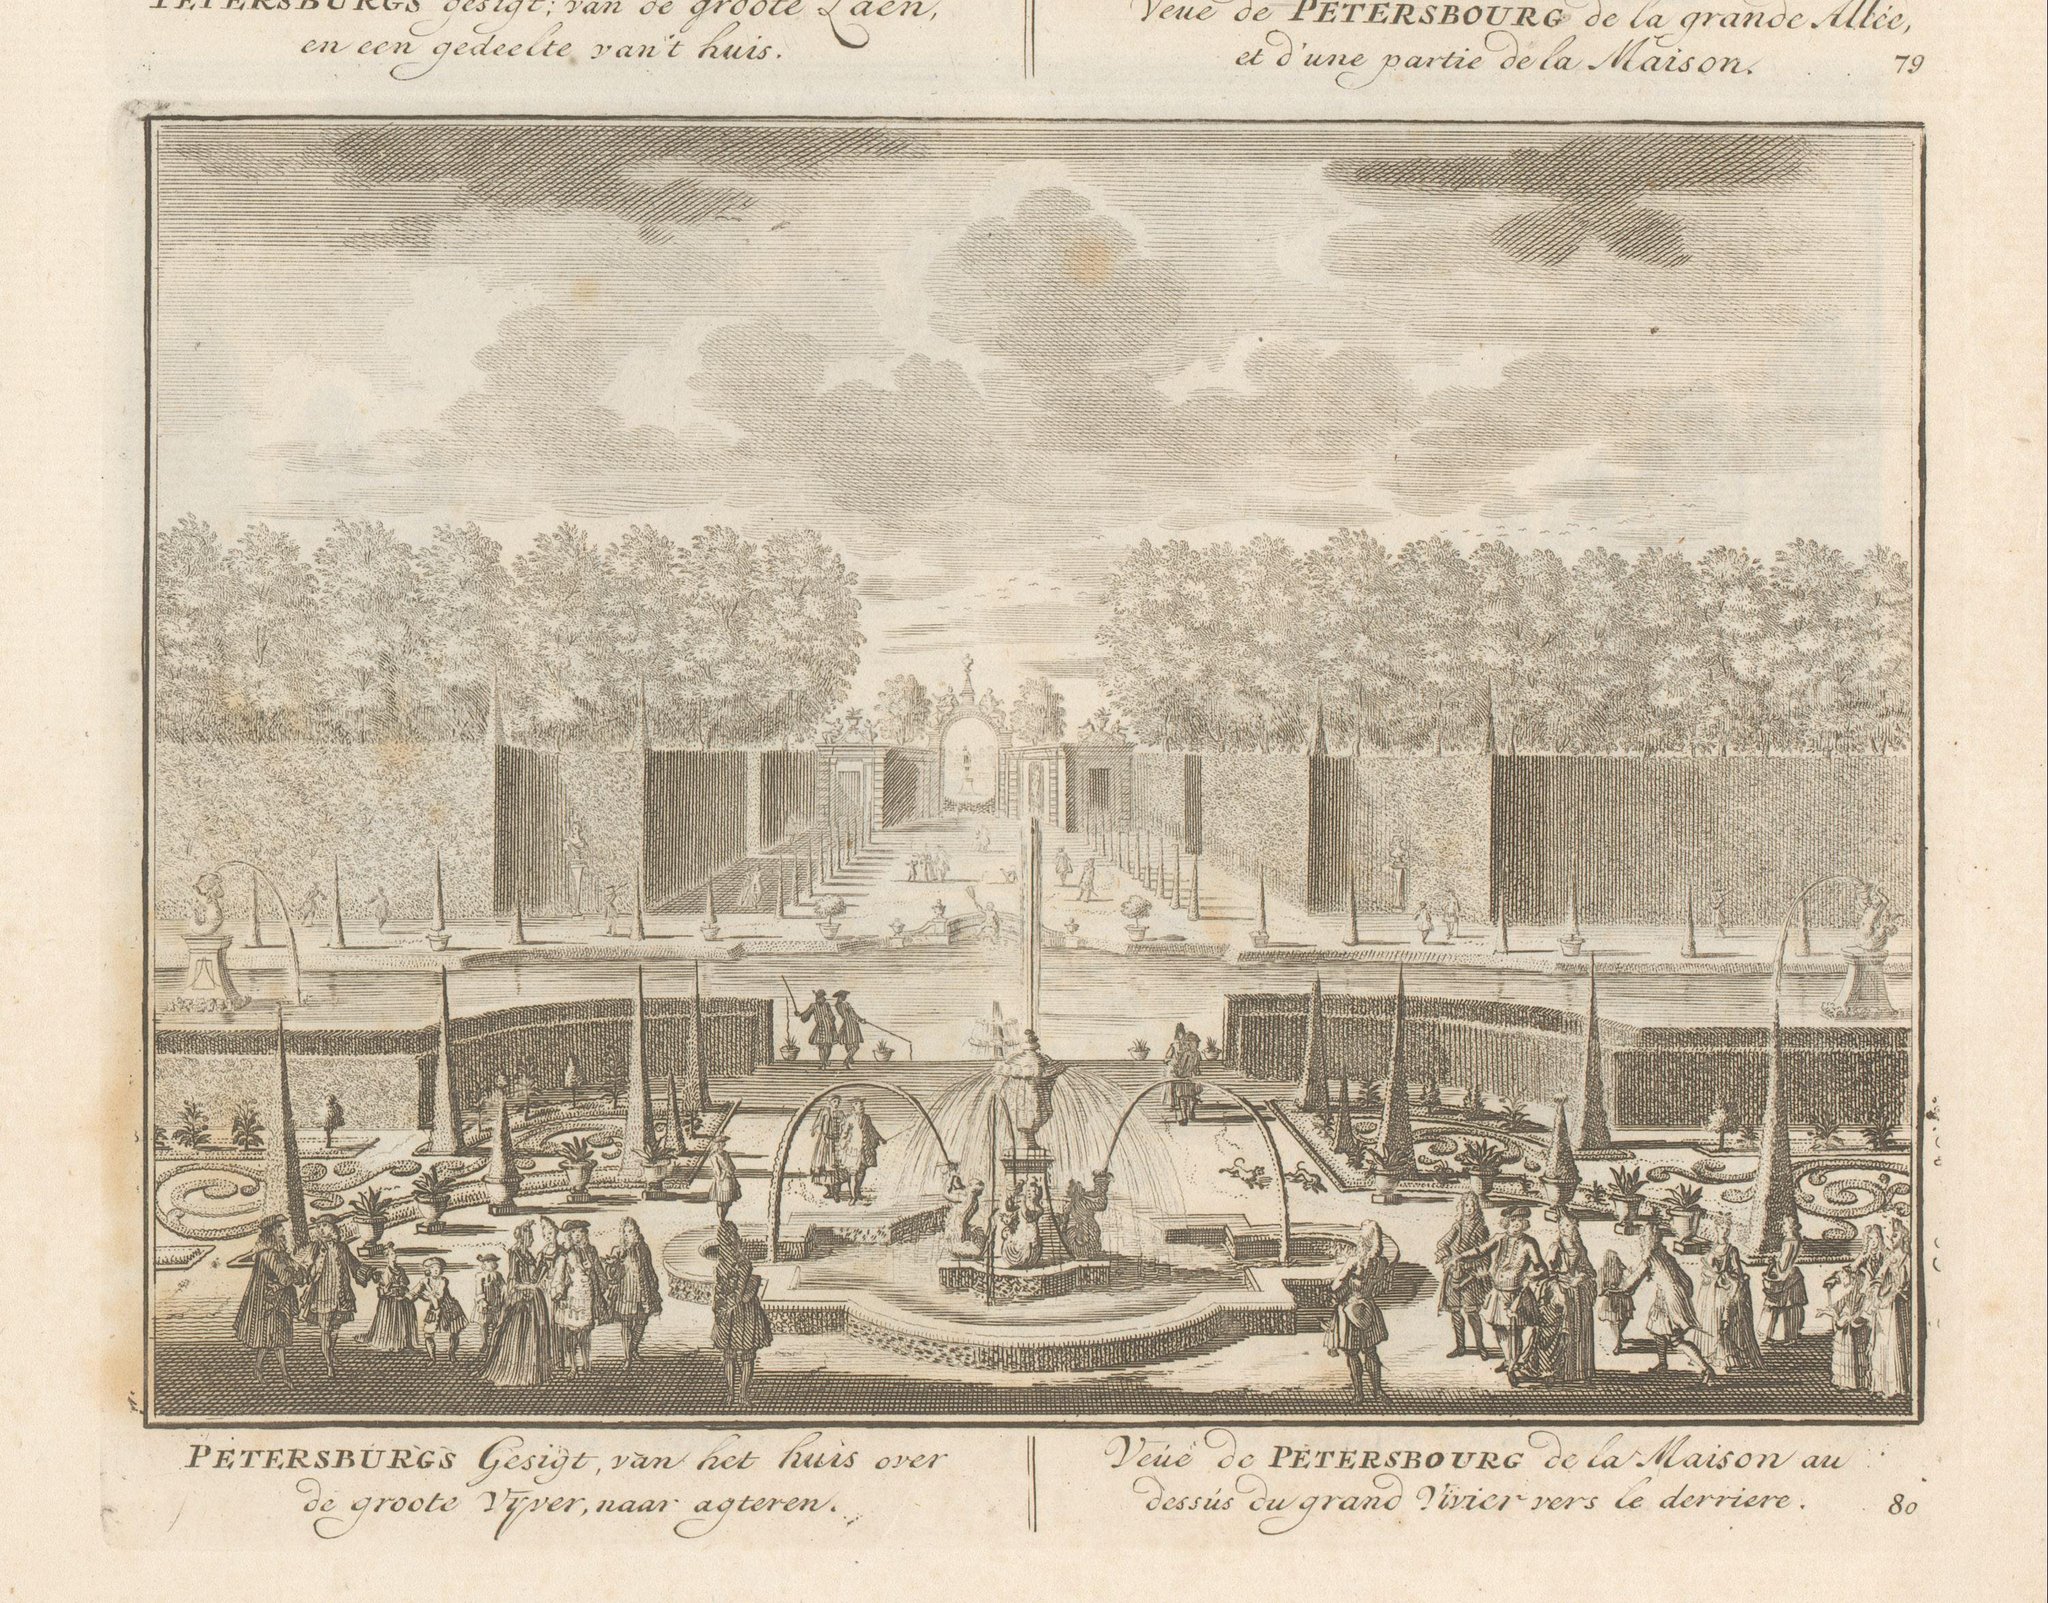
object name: album leaf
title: Gezicht op de tuin en vijver van de buitenplaats Petersburg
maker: daniël stopendaal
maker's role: print maker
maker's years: 1672-1726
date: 1790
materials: paper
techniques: engraving, etching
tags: french or architectonic garden; formal garden, garden pond, country-house, nederhorst den berg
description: Prent gebruikt in: Leth, Andries de. De zegepraalende Vecht, vertoonende verscheidene gesichten van lustplaatsen, heeren huysen en dorpen, beginnende van Uitrecht en met Muyden besluytende (...). Amsterdam: Weduwe Nicolaus Visscher, 1719. Prent ook gebruikt in: Brouërius van Nidek, Matthaeus. De Vechtstroom, van Utrecht tot Muiden (...). Amsterdam: H. Gartman, W. Vermandel en J.W. Smit, 1790.